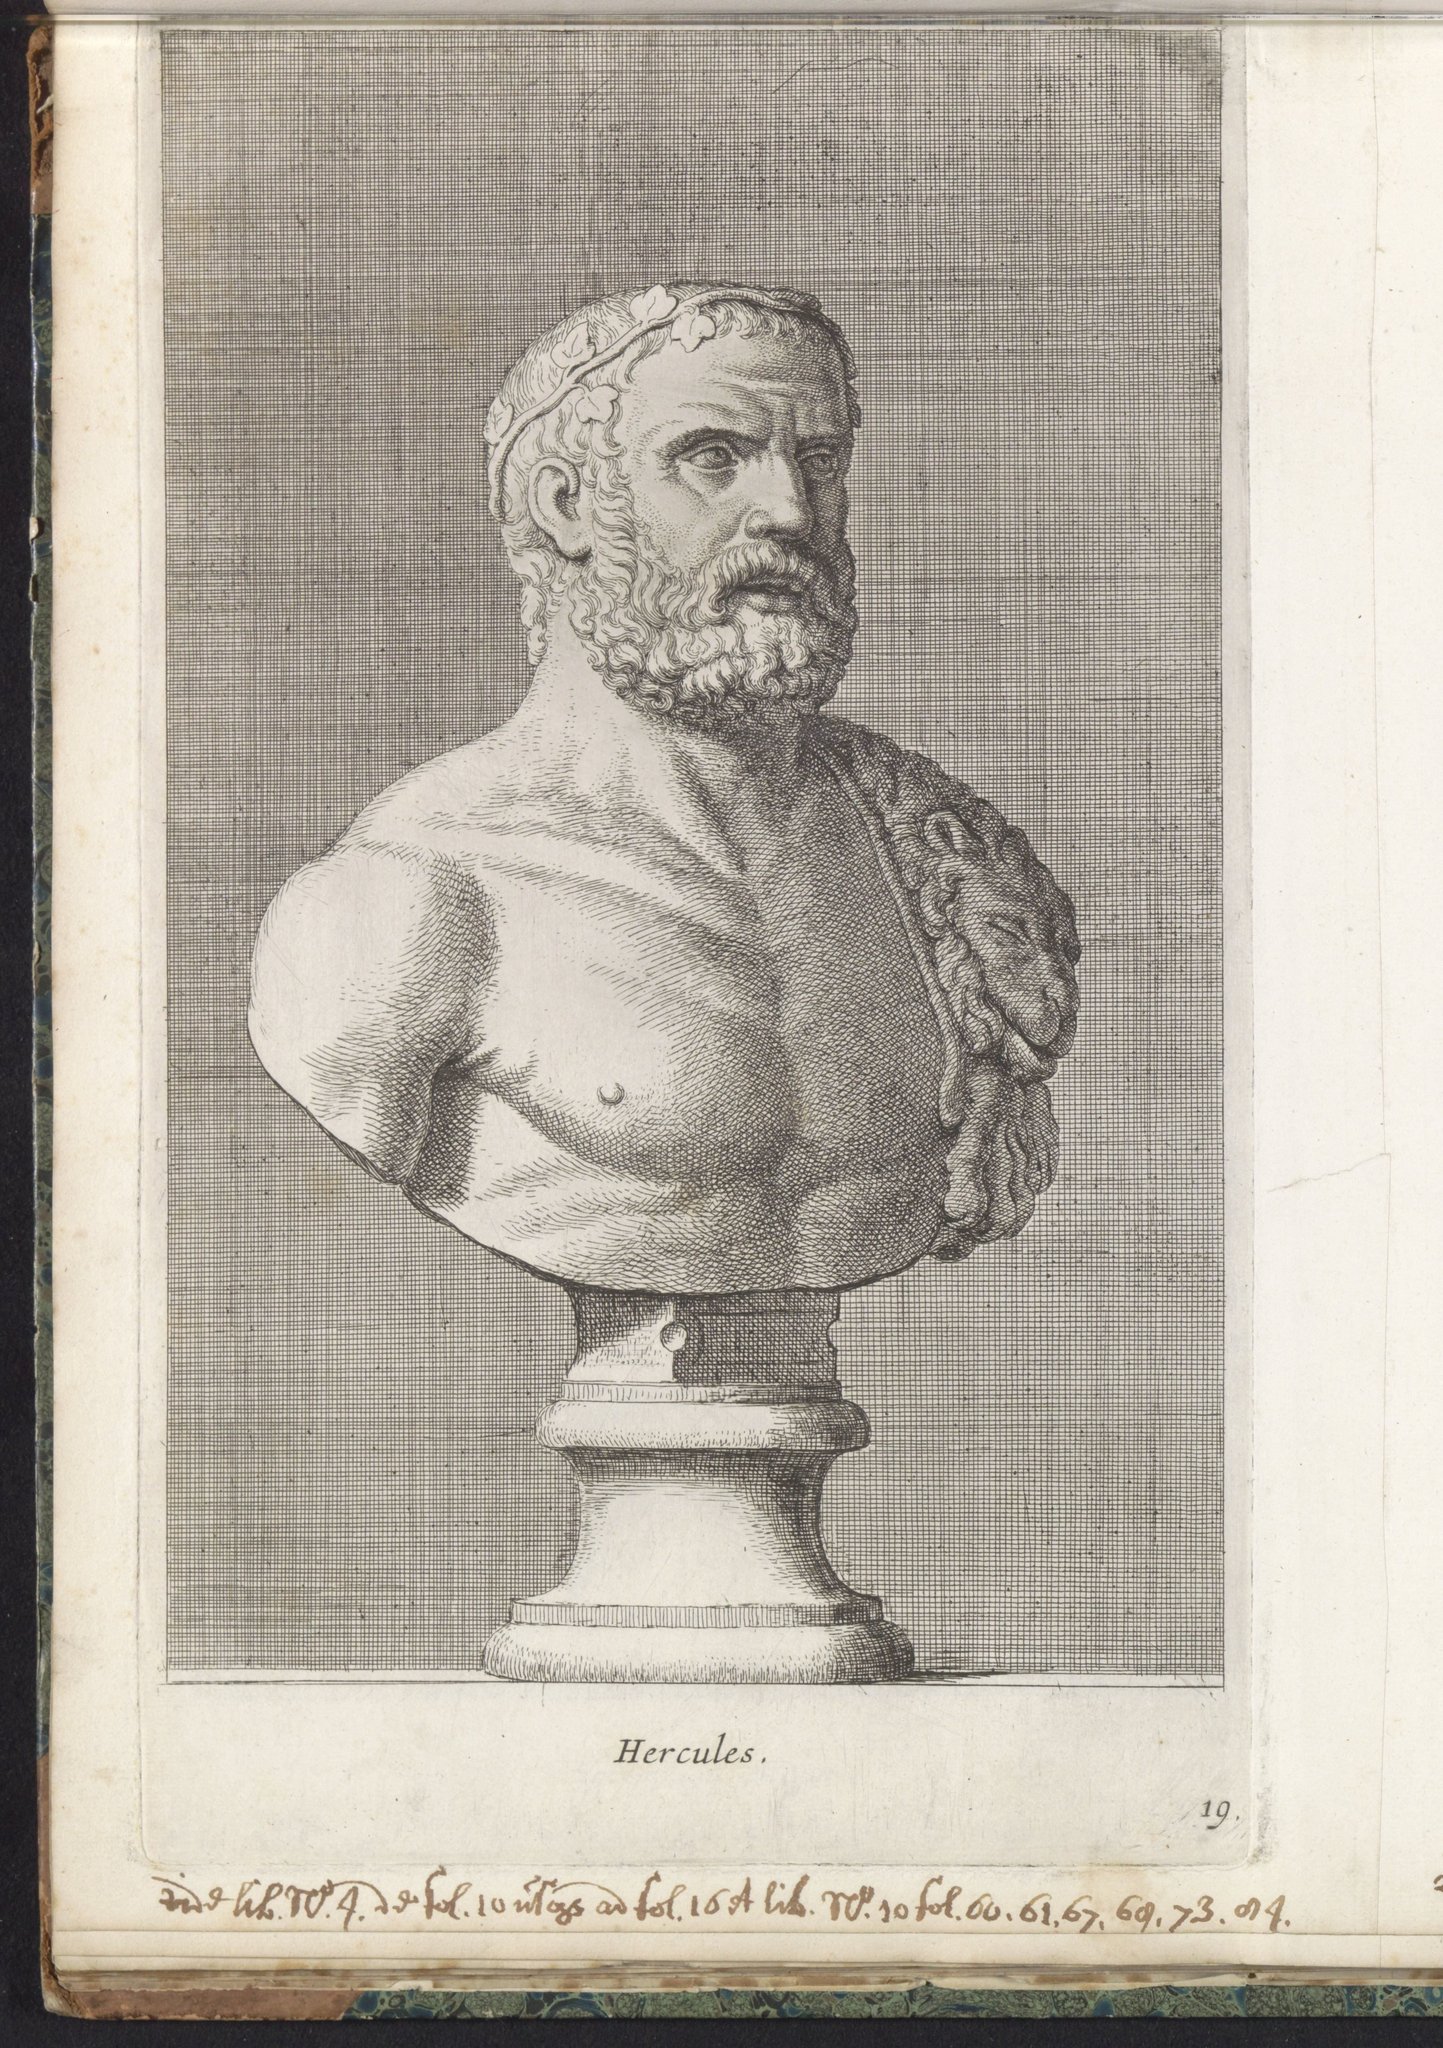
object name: print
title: Hercules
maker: hubert quellinus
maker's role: print maker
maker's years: 1619-1687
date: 1646-1670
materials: paper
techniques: engraving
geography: antwerp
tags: (story of) hercules (heracles), piece of sculpture, reproduction of a piece of sculpture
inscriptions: number: ‘49’, inscription: ‘Vide lib. No. 4de fol. 10 ...’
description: Klassieke buste van Hercules. Over zijn schouder hangt de huid van een leeuw. De prent maakt deel uit van een album met een serie prenten naar de sculpturen in de verzameling van Gerard Reynst.